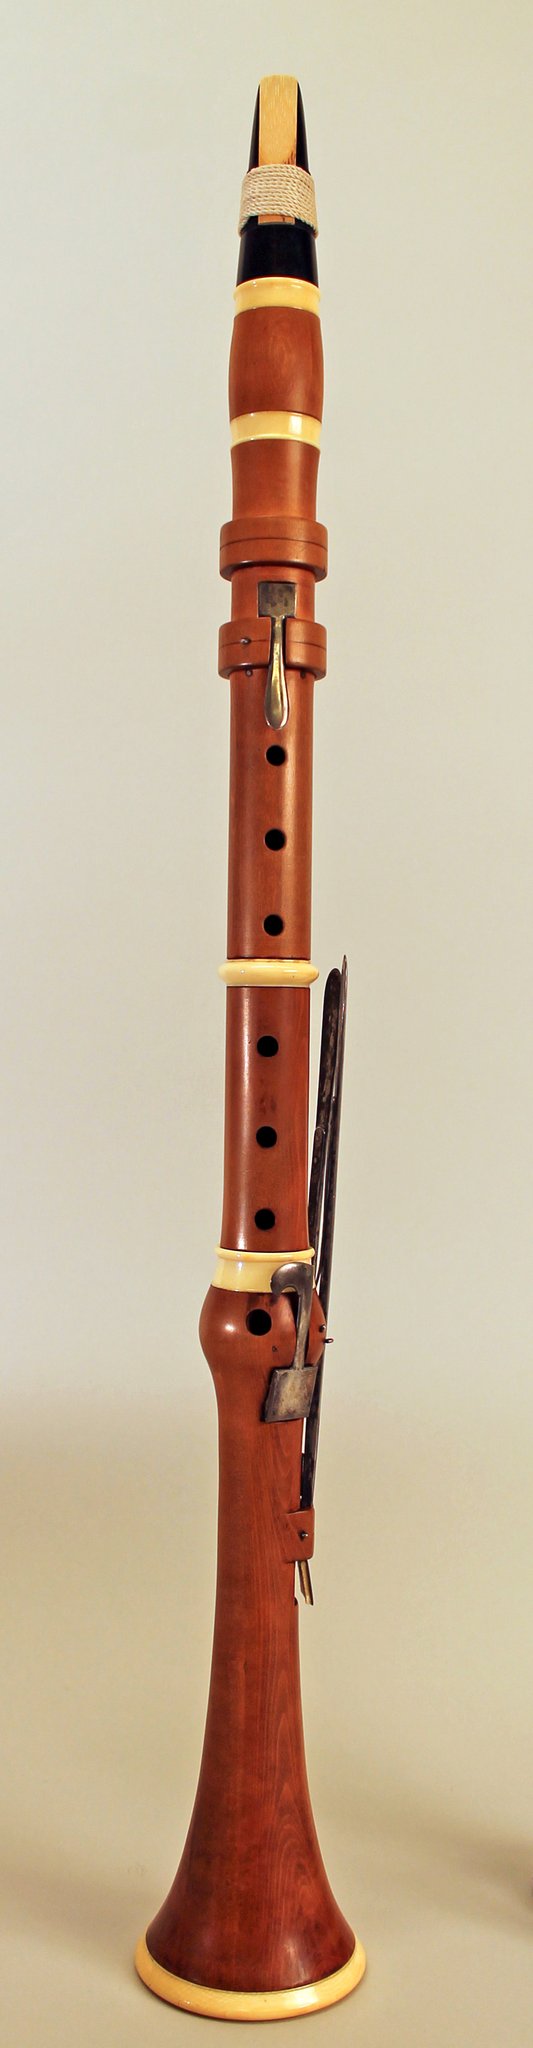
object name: clarinet in c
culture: french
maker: Anonymous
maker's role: maker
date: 1800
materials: wood, ivory, silver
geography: france